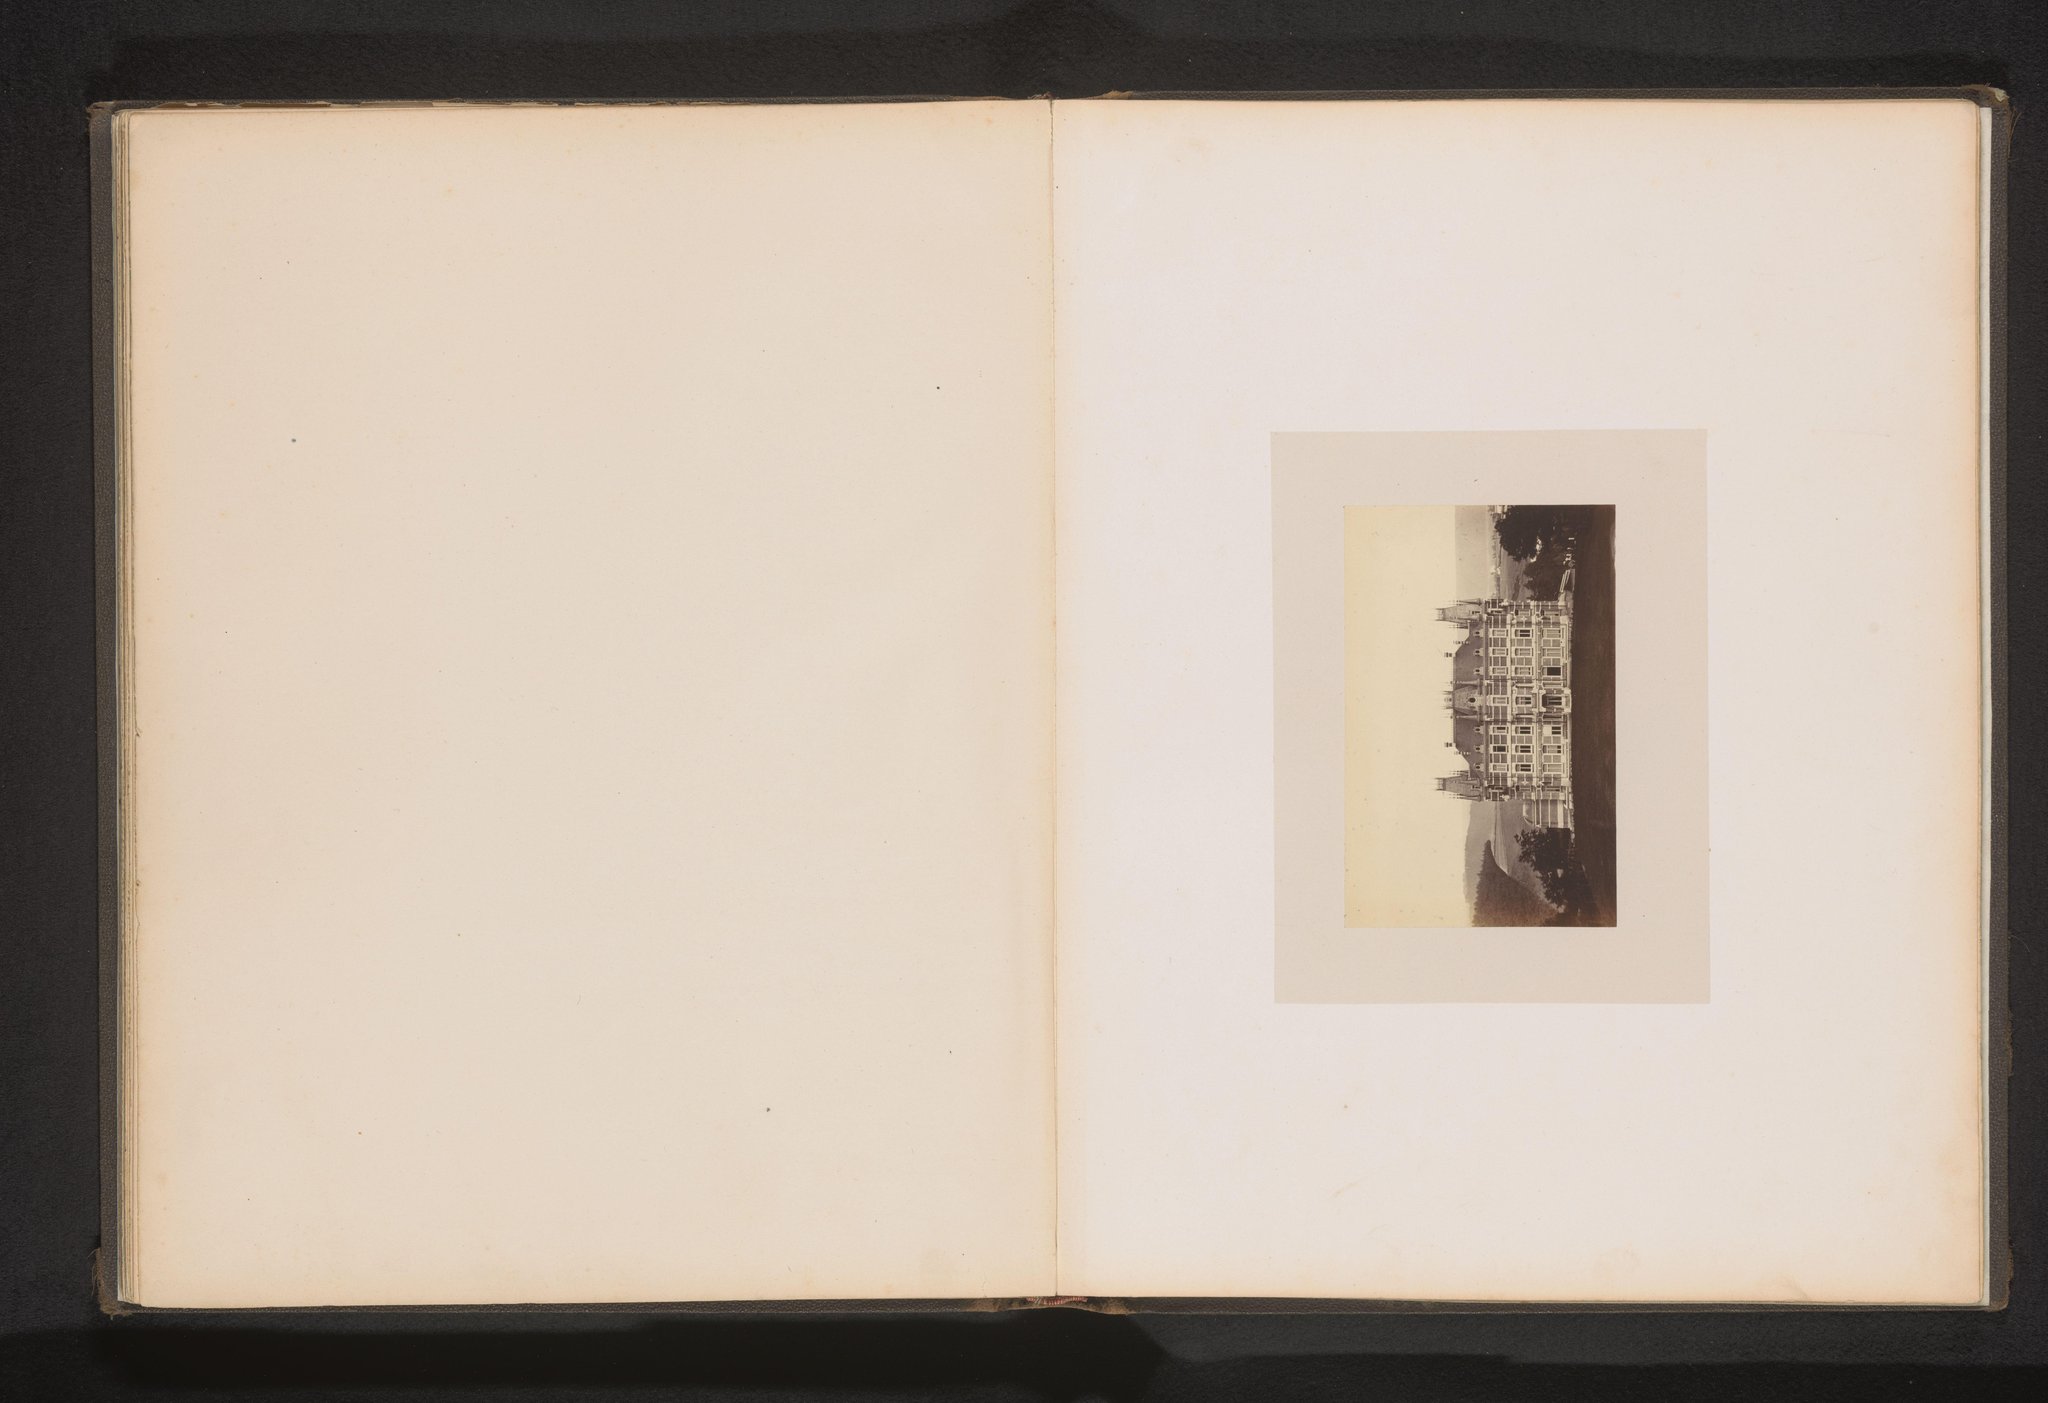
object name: photograph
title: Gezicht op Château de Marlagne te Wépion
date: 1862-1867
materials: photographic support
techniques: albumen print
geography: wépion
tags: landscape with tower or castle